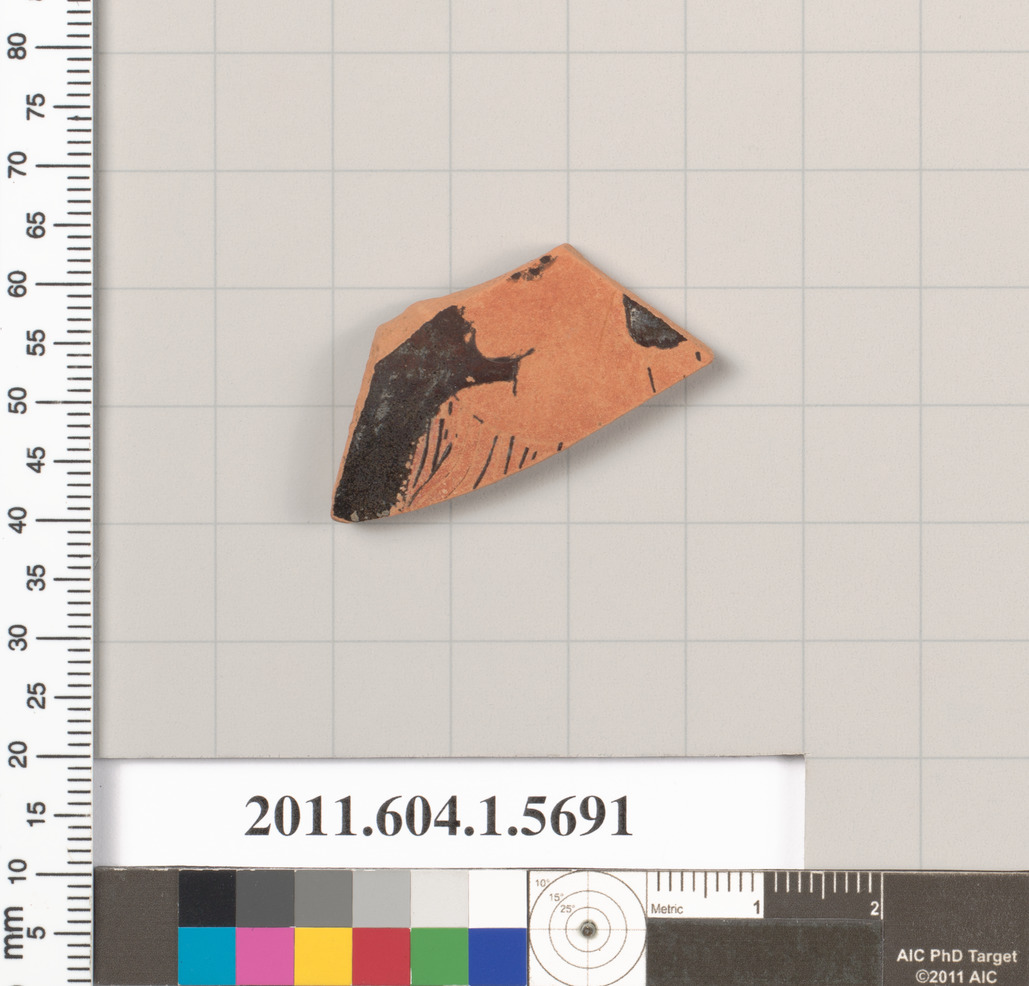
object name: kylix fragment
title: Terracotta fragment of a kylix (drinking cup)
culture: greek, attic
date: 475-451 BCE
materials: terracotta